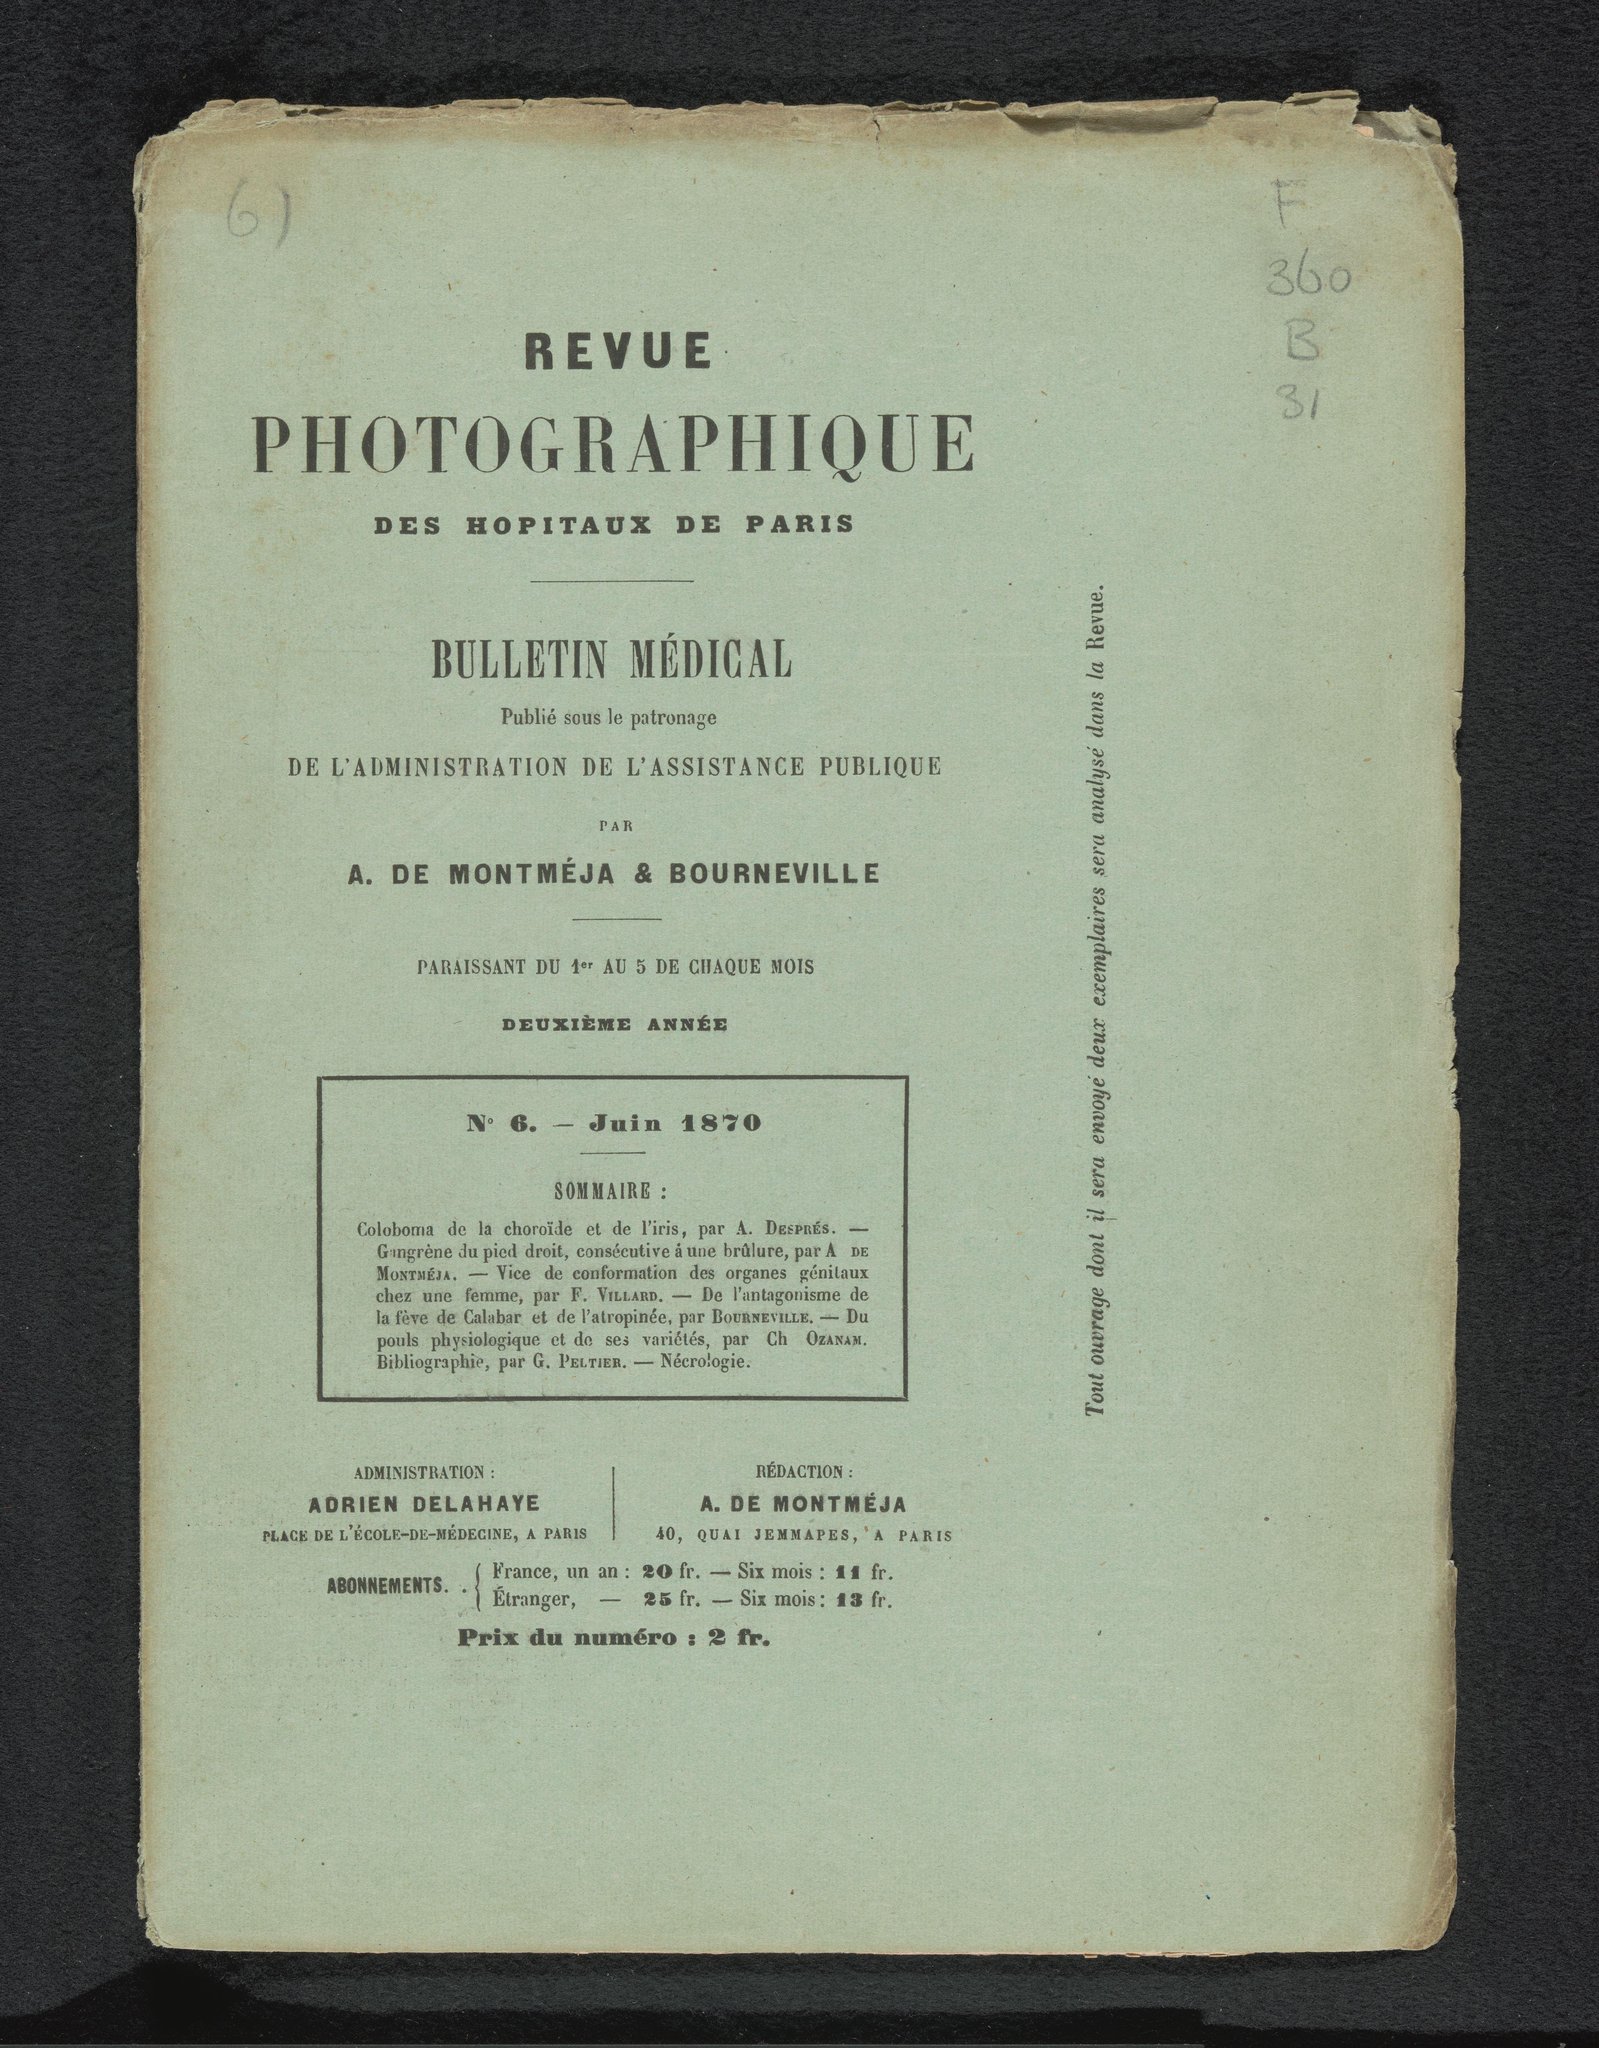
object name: magazine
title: Revue photographique des hôpitaux de Paris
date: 1870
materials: paper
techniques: printing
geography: paris